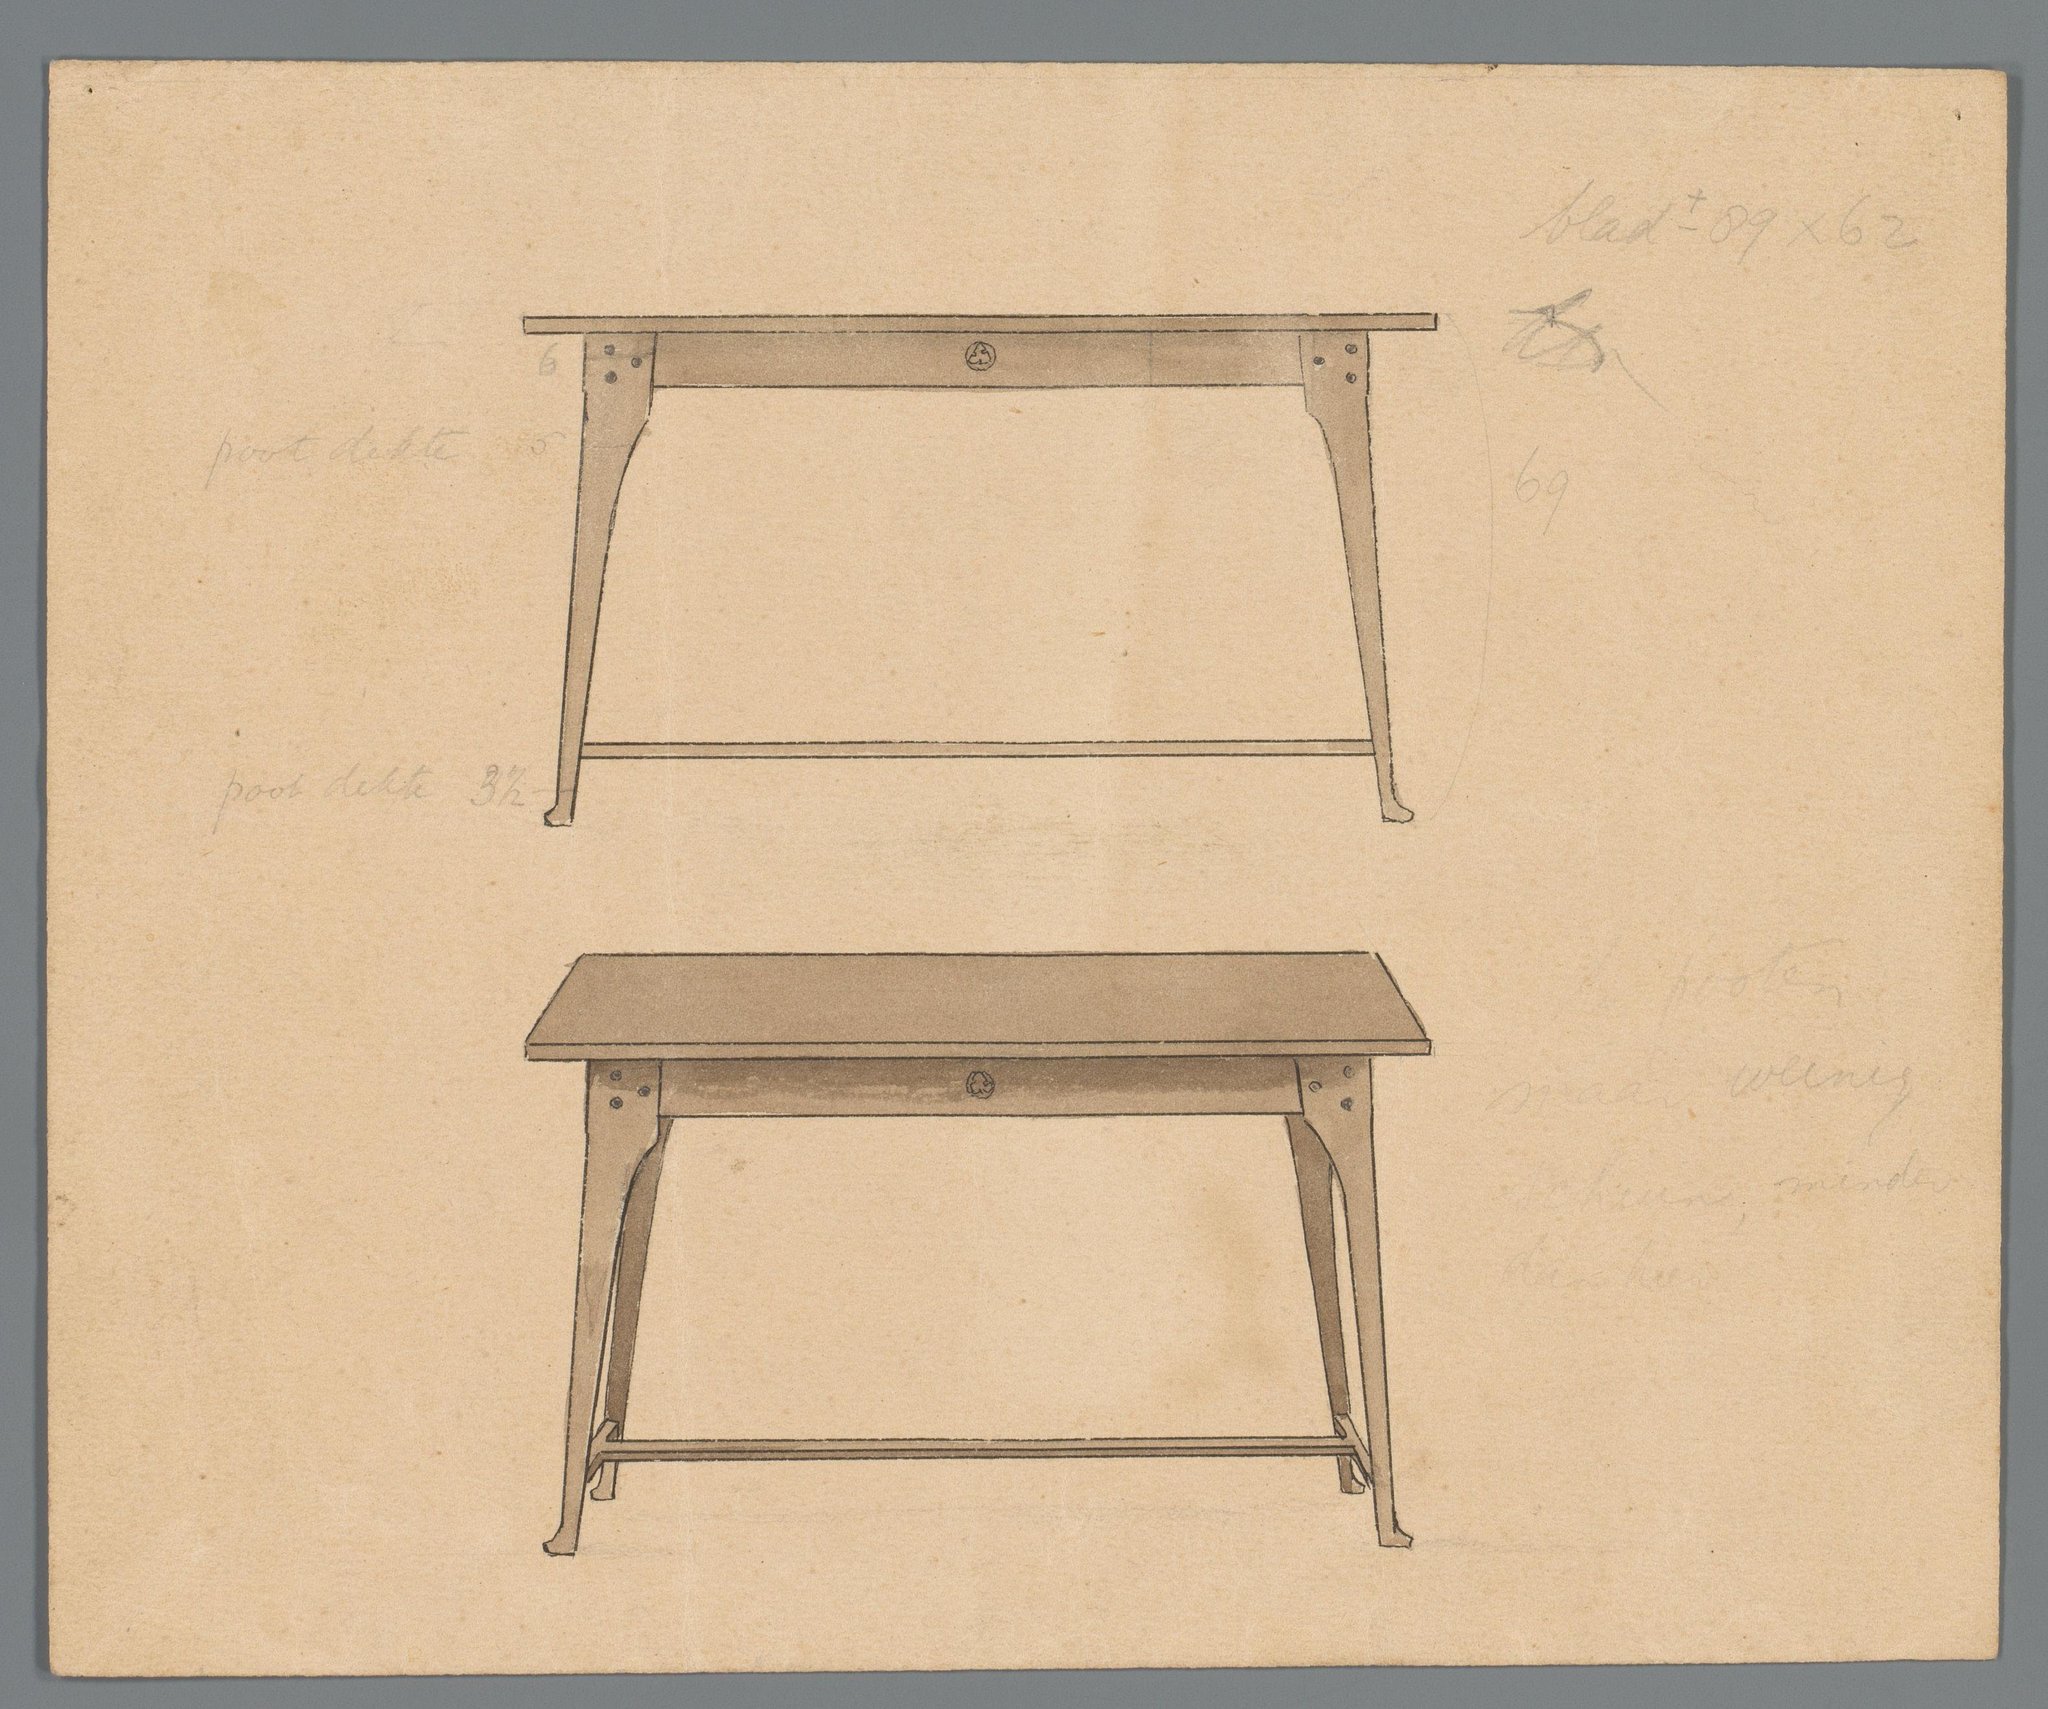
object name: design drawing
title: Ontwerp voor een tafel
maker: gust van de wall perné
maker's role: draughtsman, painter, print maker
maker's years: 1877-1911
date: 1887-1911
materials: ink, paper, pencil, watercolor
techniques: brush, pen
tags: table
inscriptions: collector's mark: Lugt 2228